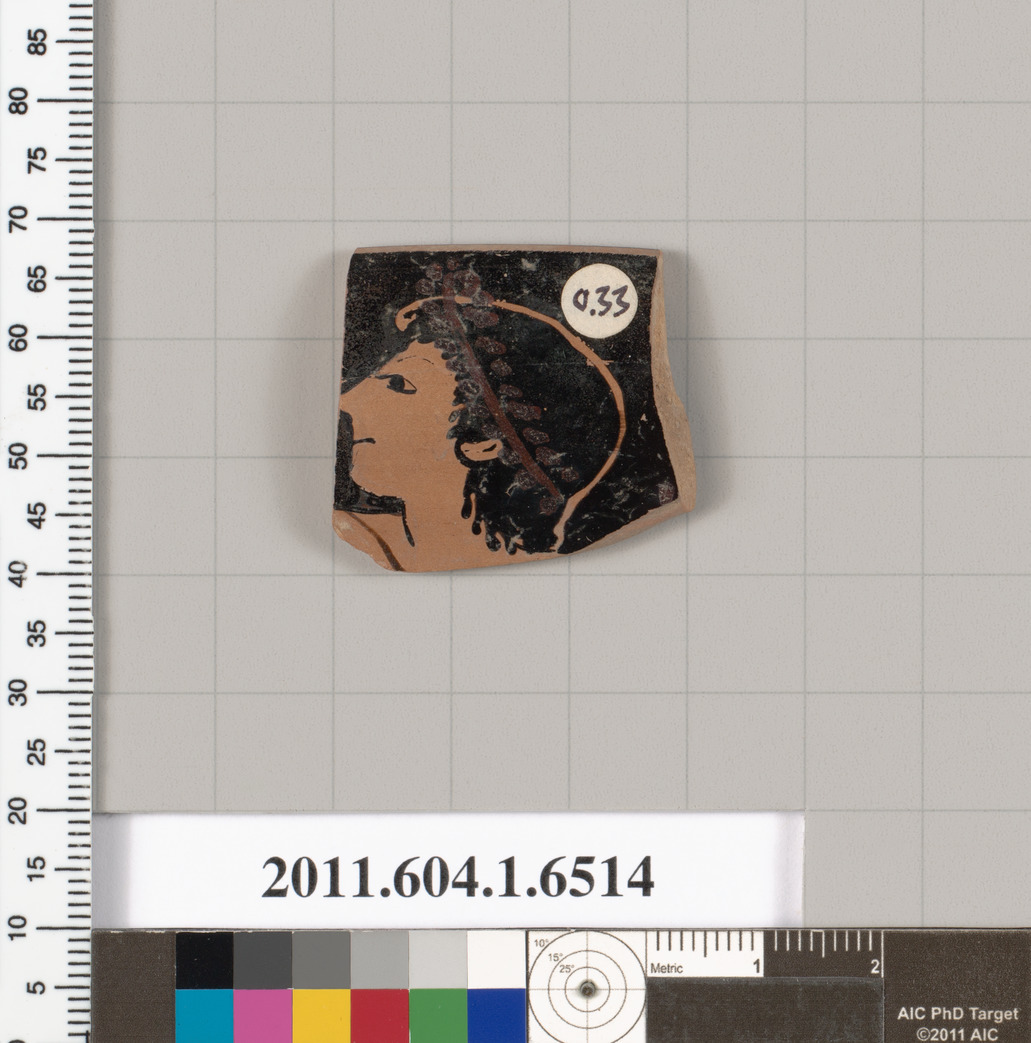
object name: kylix fragment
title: Terracotta rim fragment of a kylix (drinking cup)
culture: greek, attic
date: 490-480 BCE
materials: terracotta